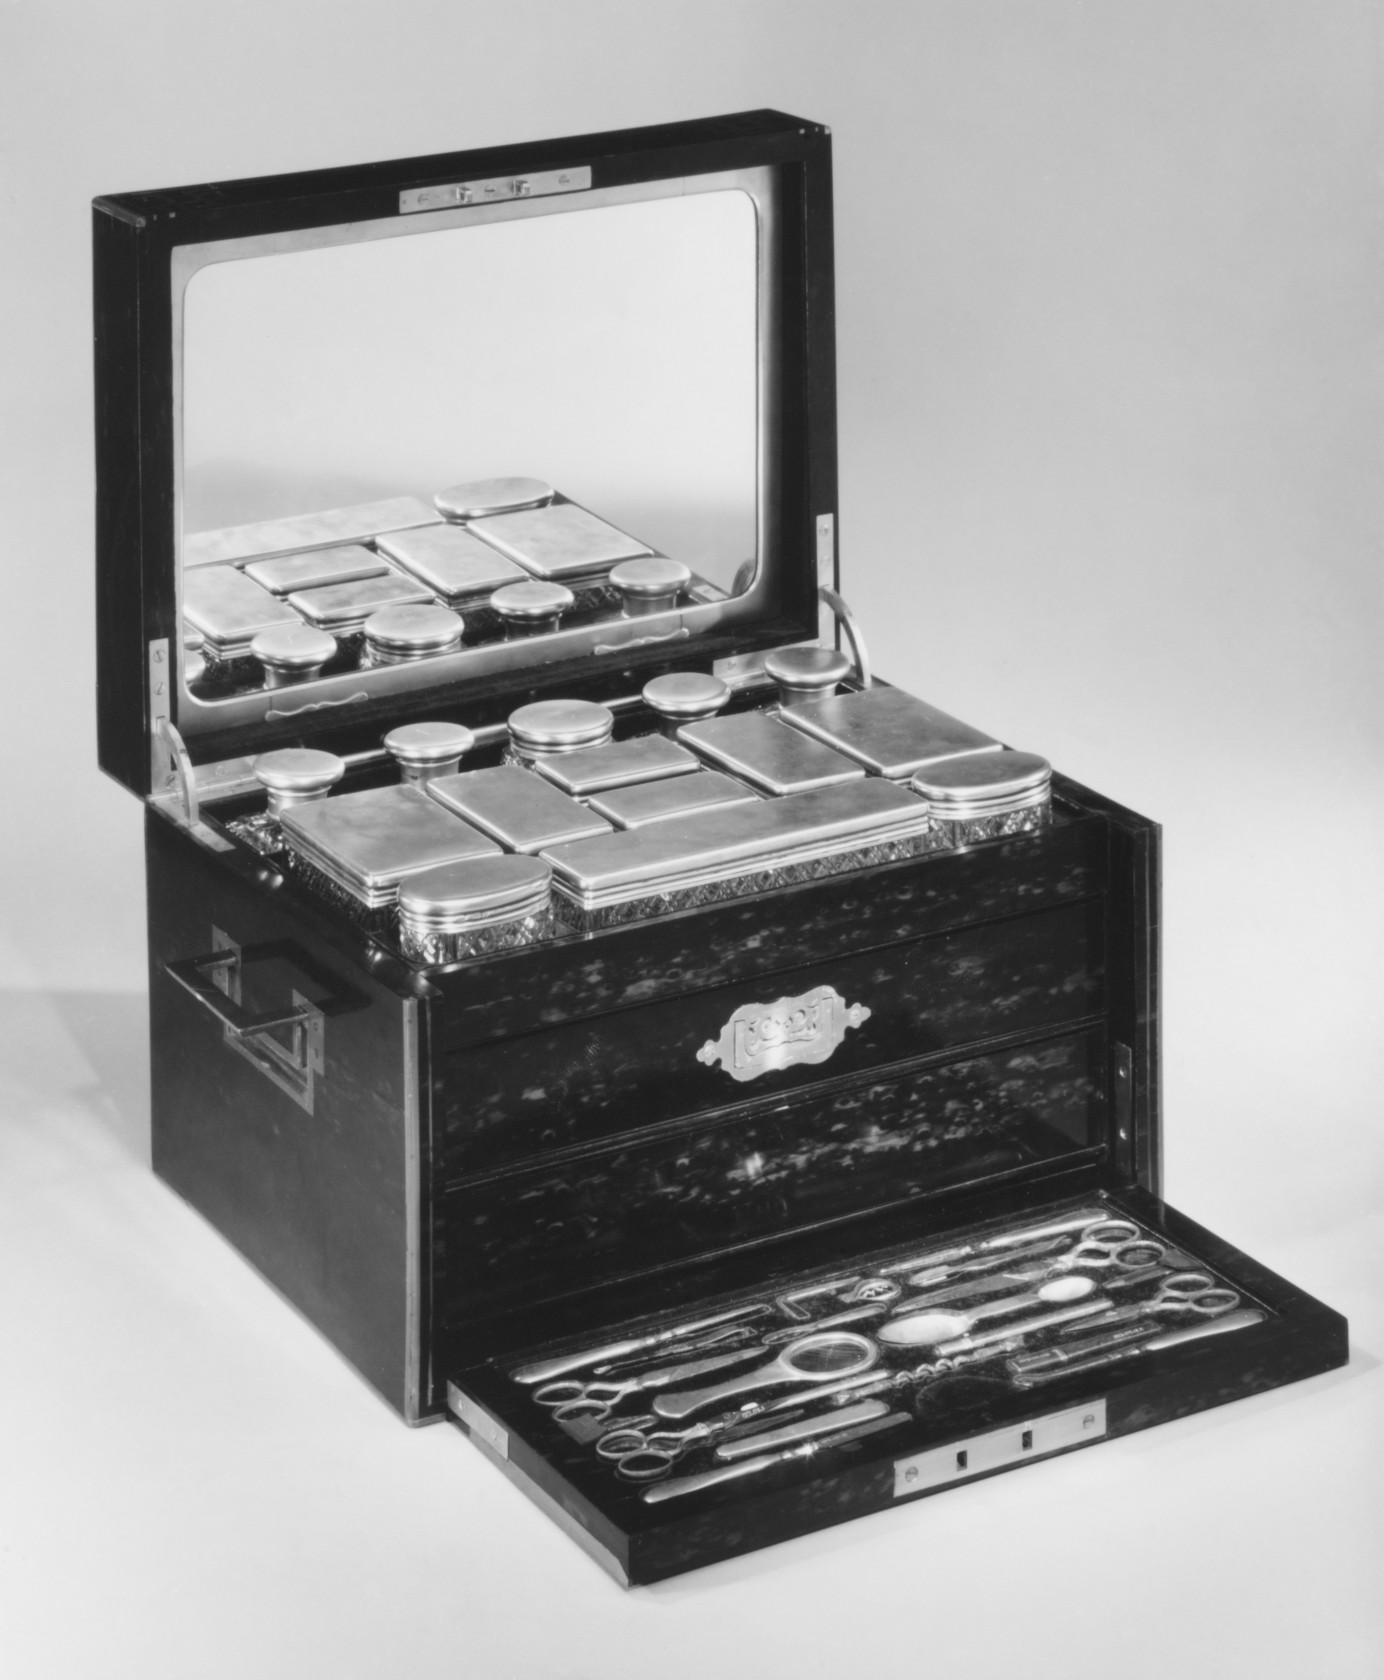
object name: traveling set case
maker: hunt & roskell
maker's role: maker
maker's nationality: british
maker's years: 1843-1897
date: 1874-1875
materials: brass, wood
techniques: veneering